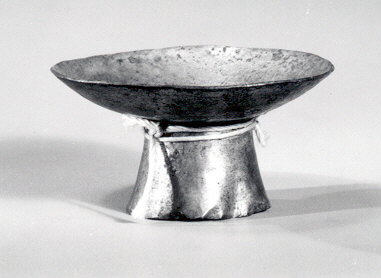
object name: bowl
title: Silver Miniature Pedestal Bowl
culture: chancay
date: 1001-1200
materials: silver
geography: peru